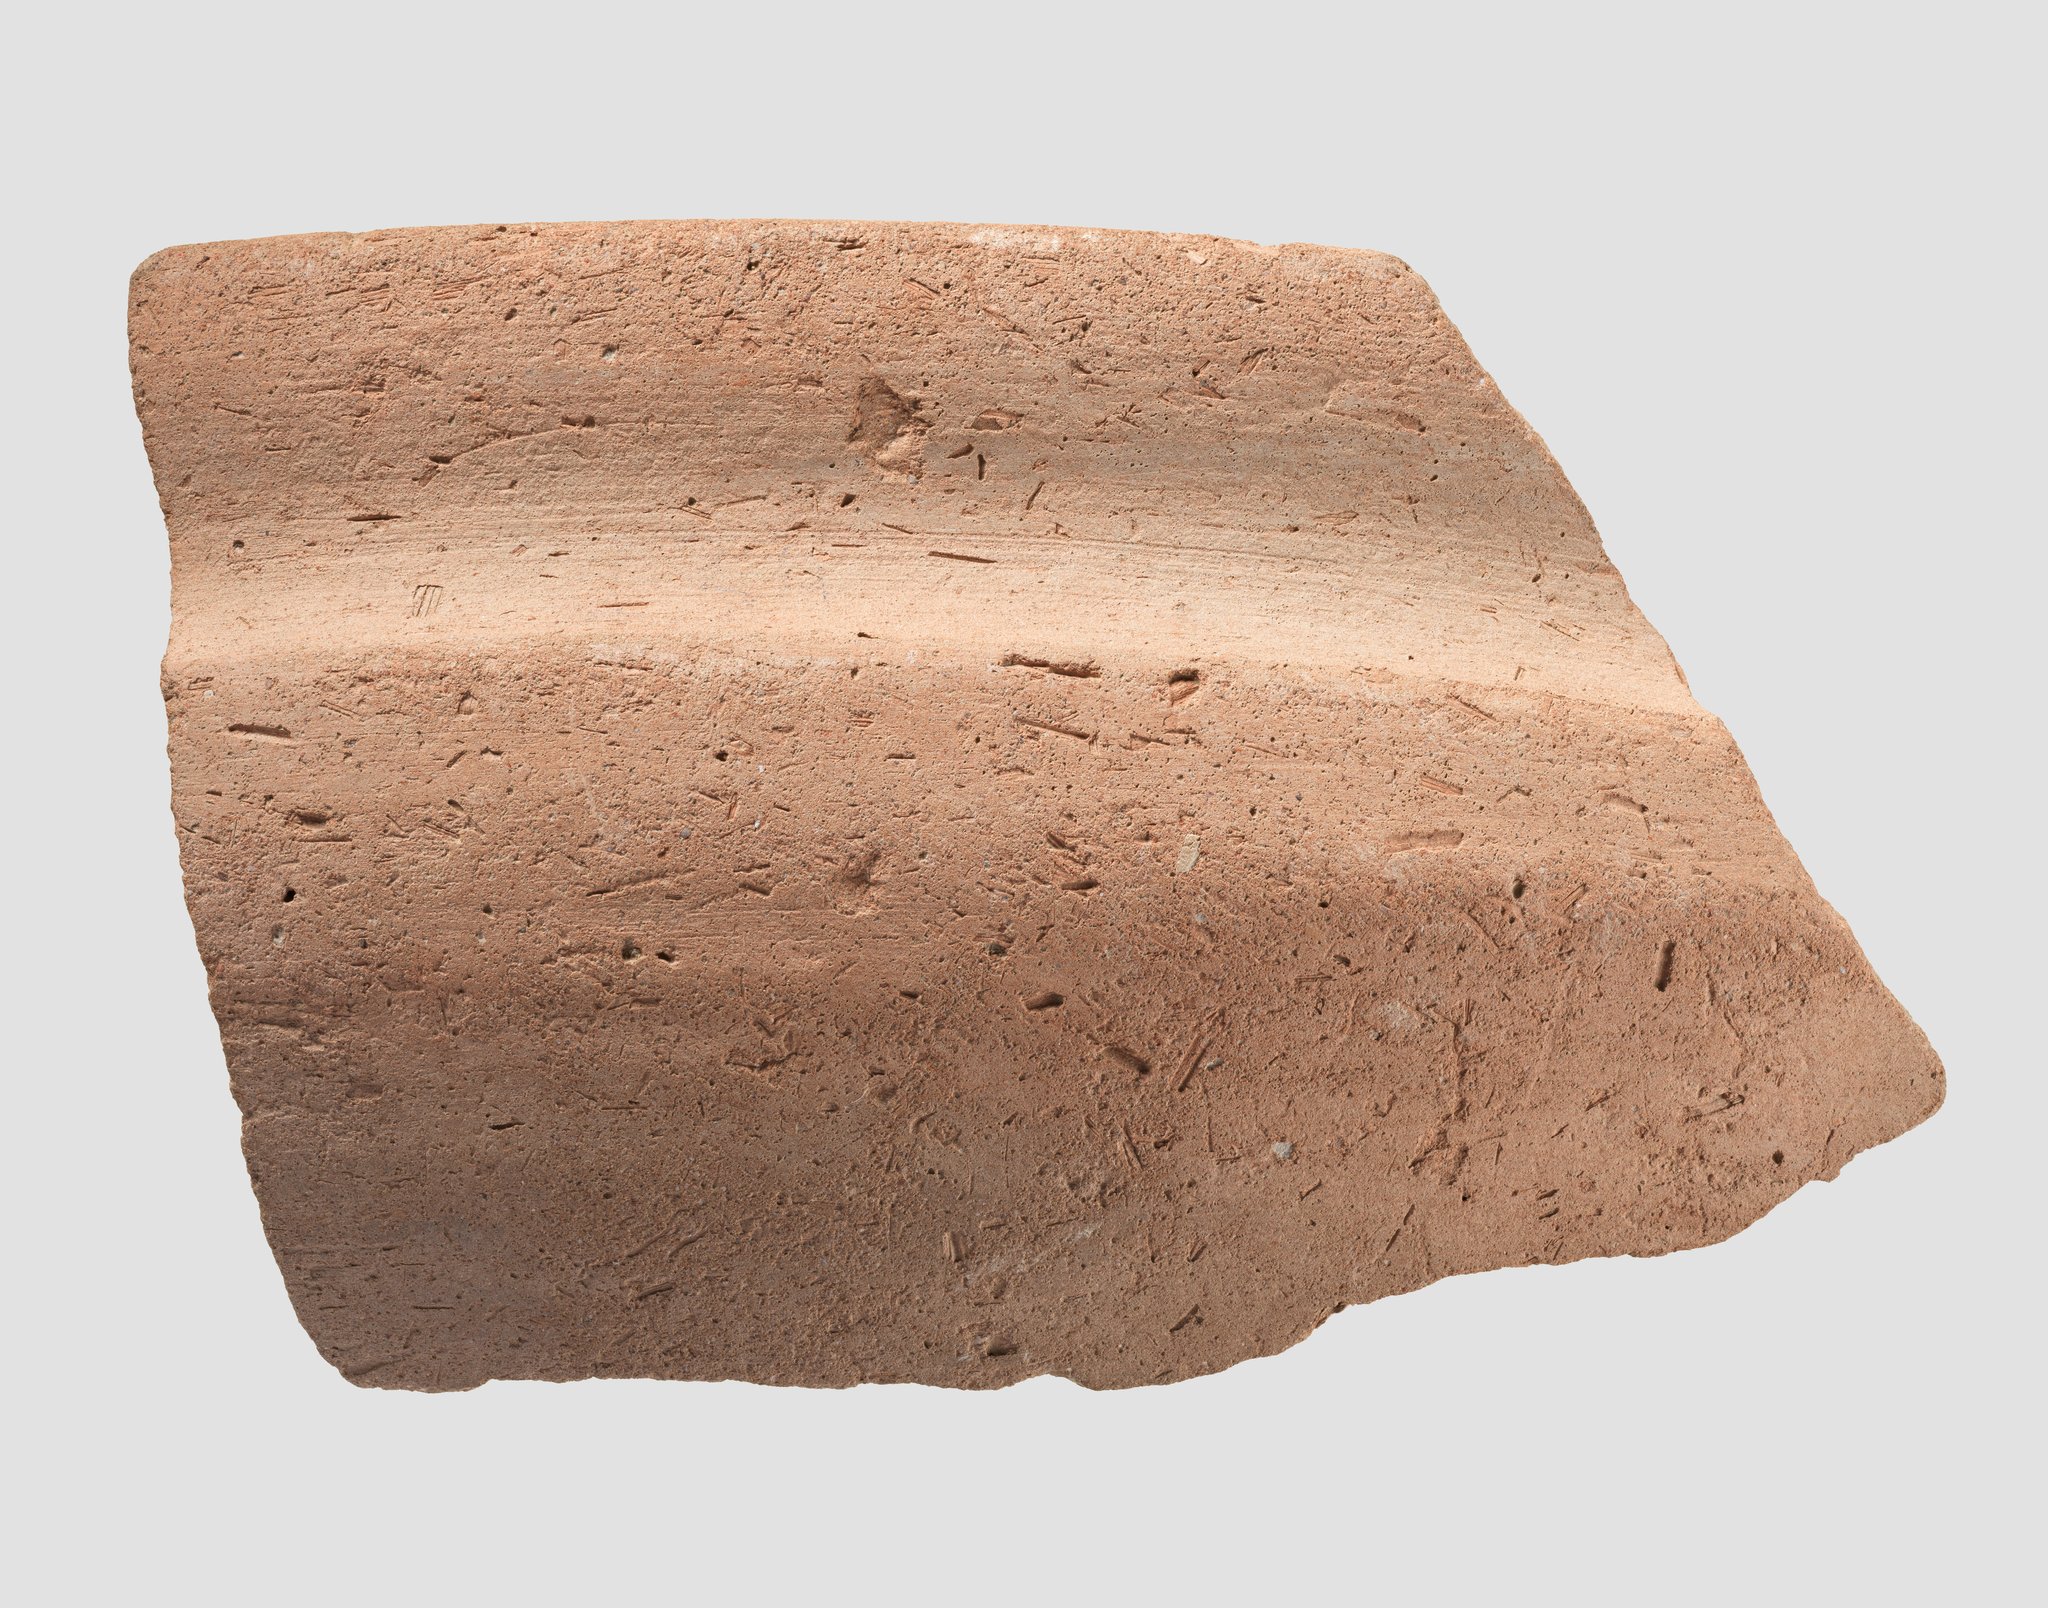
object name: bowl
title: Bowl rim sherd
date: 2333-2001 BCE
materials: ceramic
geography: mesopotamia